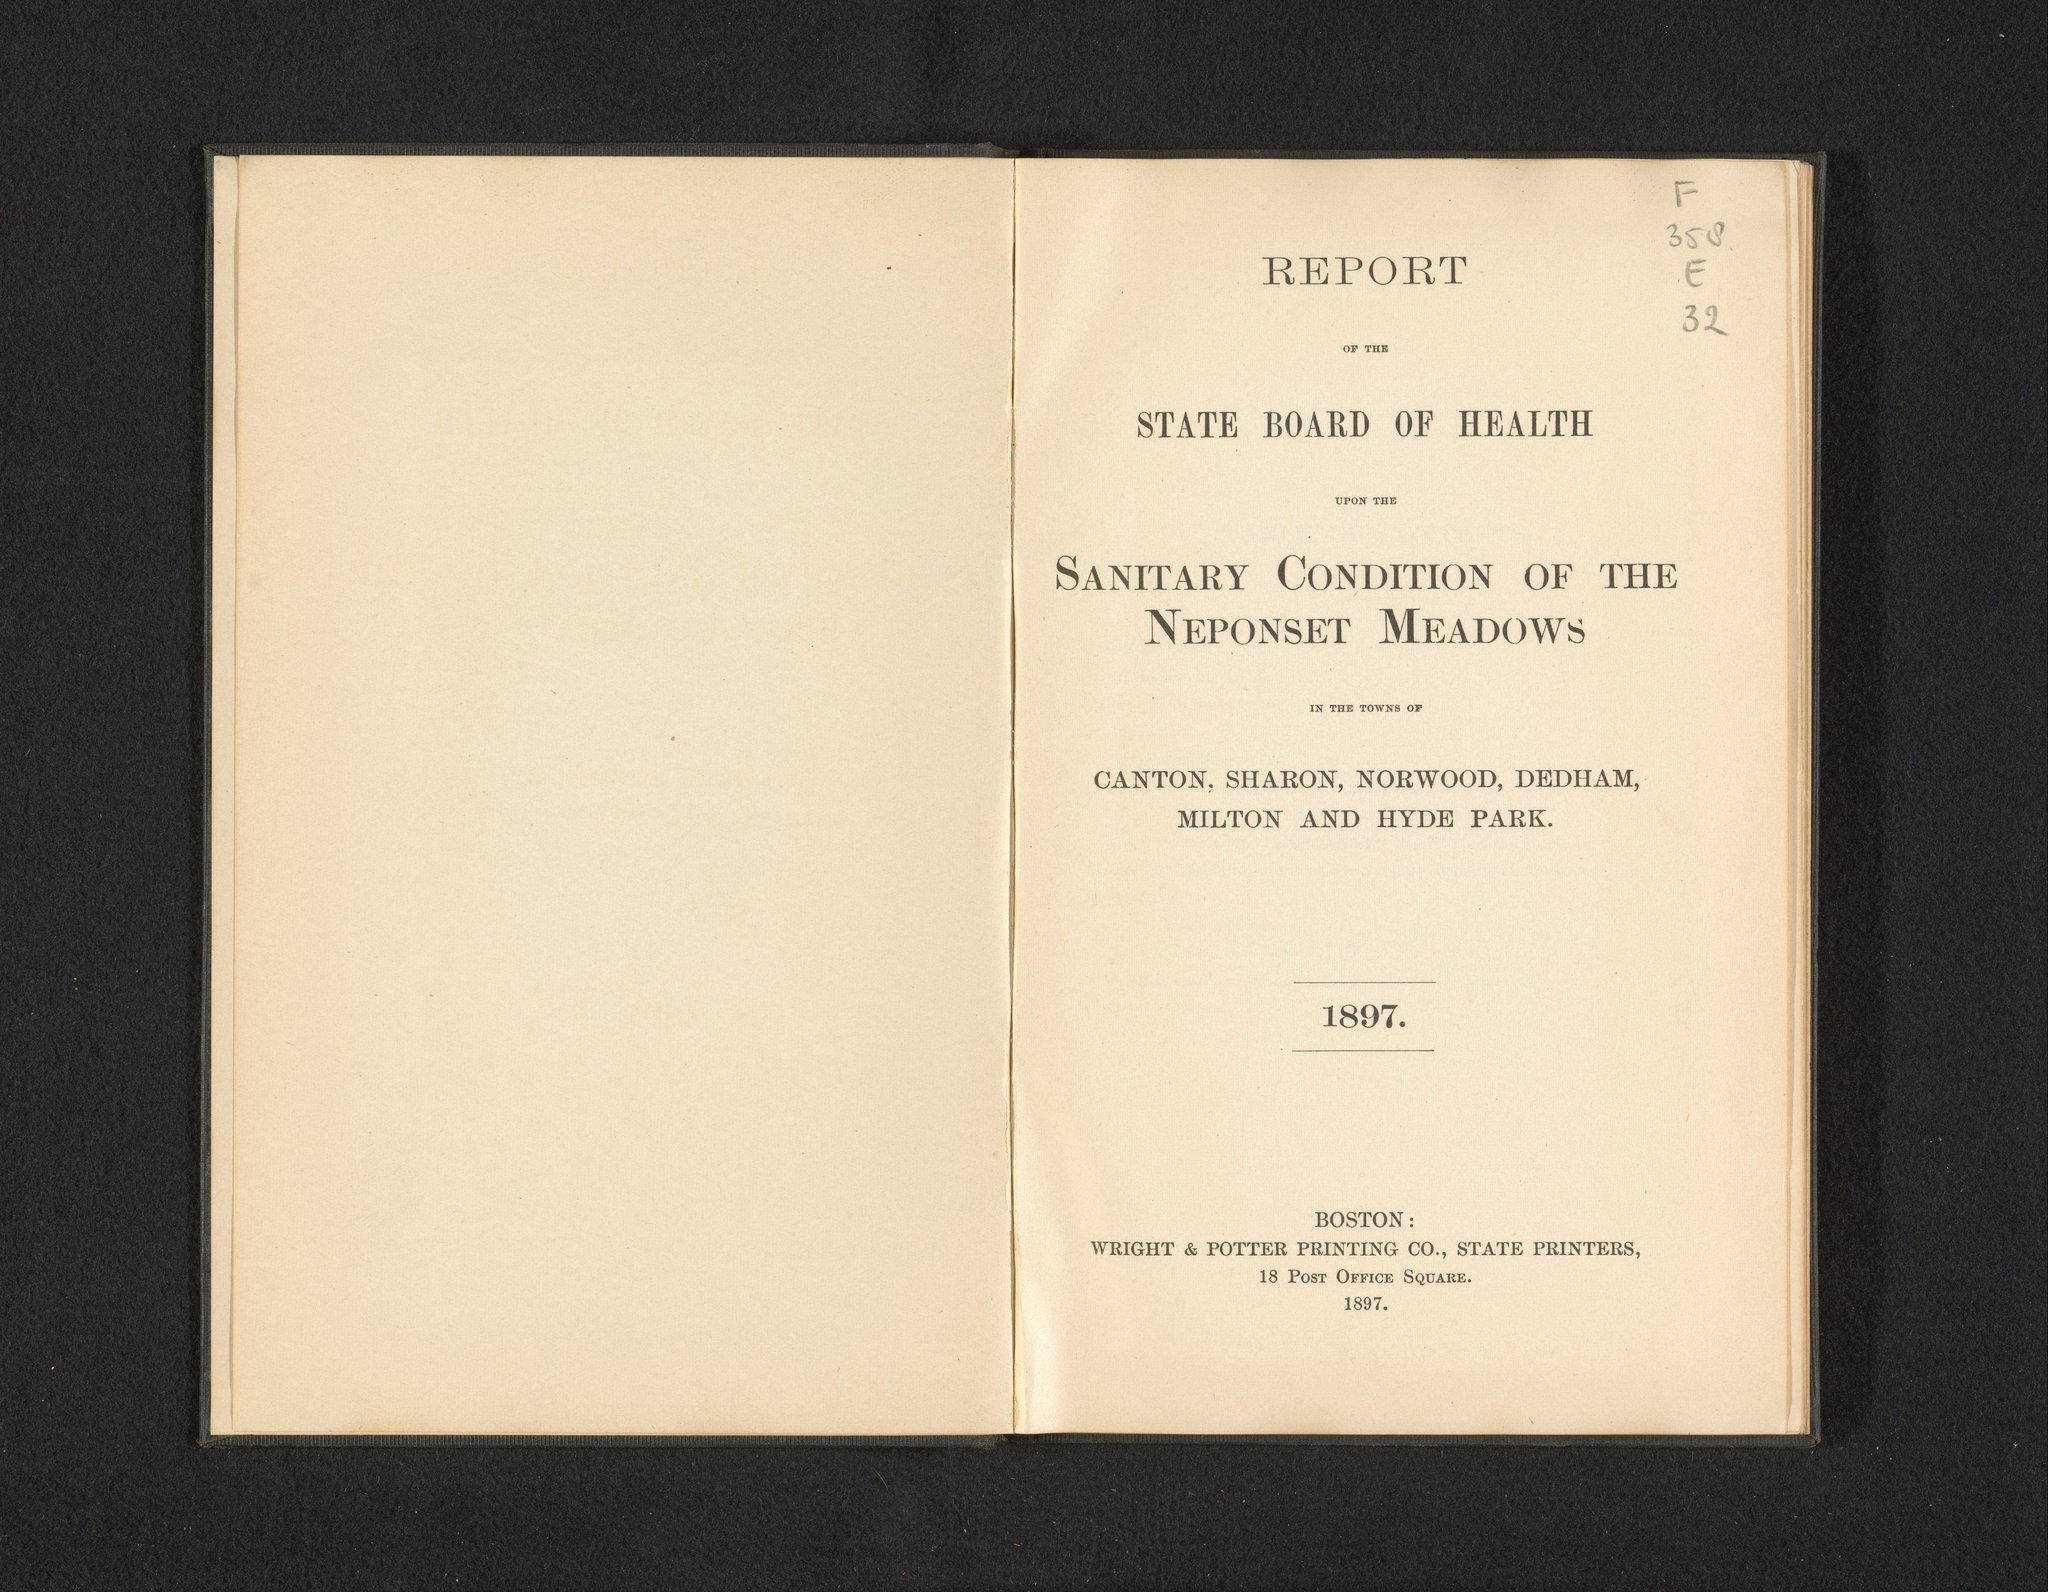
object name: book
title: Report of the State Board of Health upon the sanitary condition of the Neponset meadows in the towns of Canton, Sharon, Norwood, Dedham, Milton and Hyde Park: 1897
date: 1897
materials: cardboard, linen, paper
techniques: photograph, lithograph, printing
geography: boston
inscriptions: bookplate: ‘Library of Frankwood’